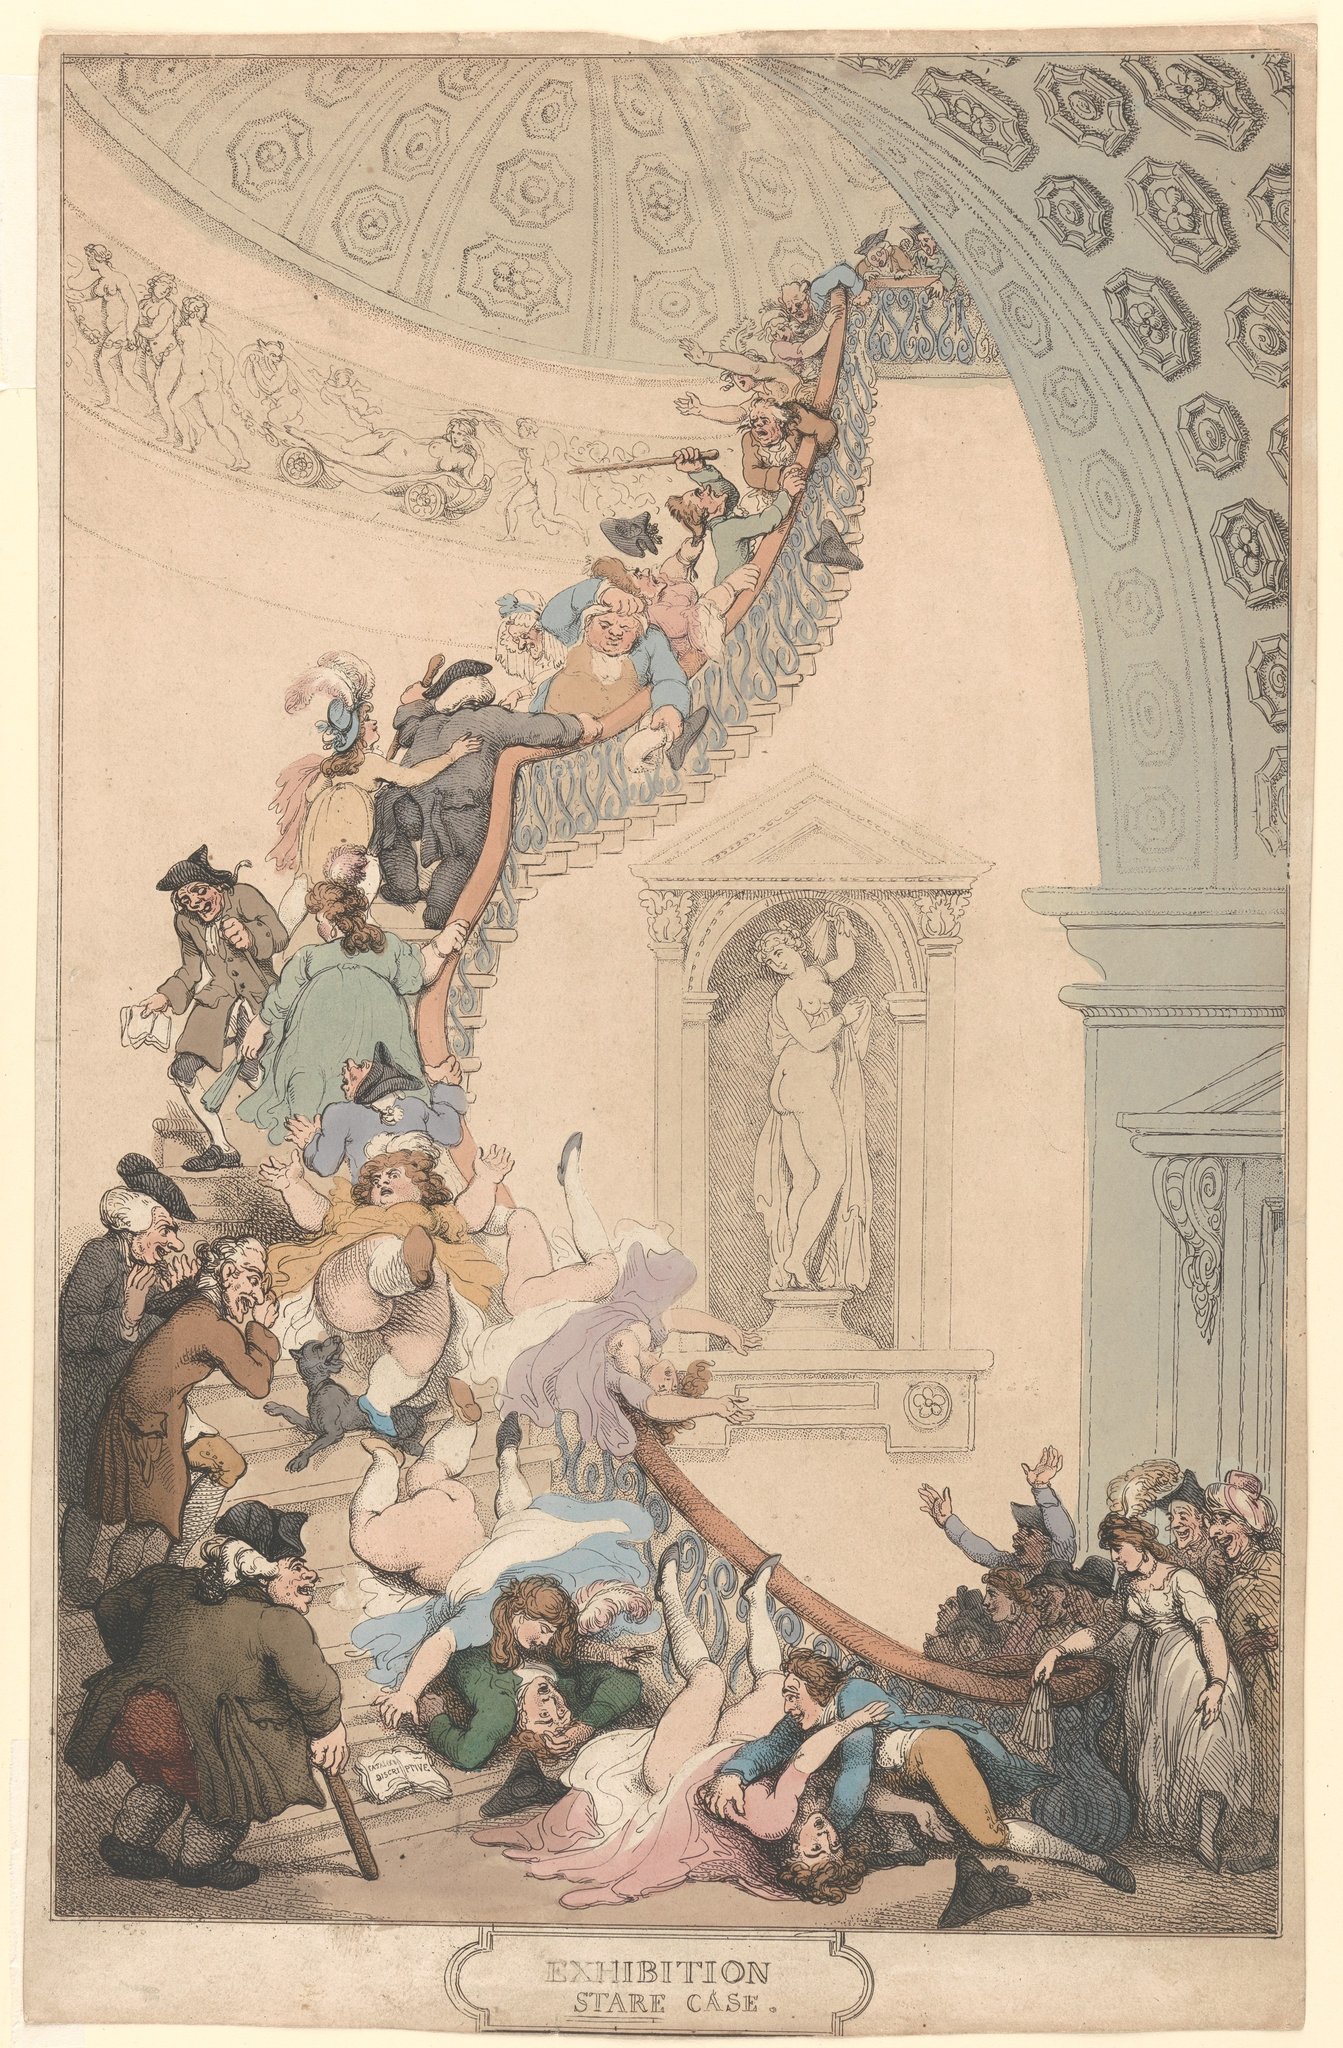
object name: print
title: The Exhibition "Stare-Case"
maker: thomas rowlandson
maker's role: artist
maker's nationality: british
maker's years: 1757-1827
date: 1811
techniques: etching, hand coloring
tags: satire,stairs,men,women